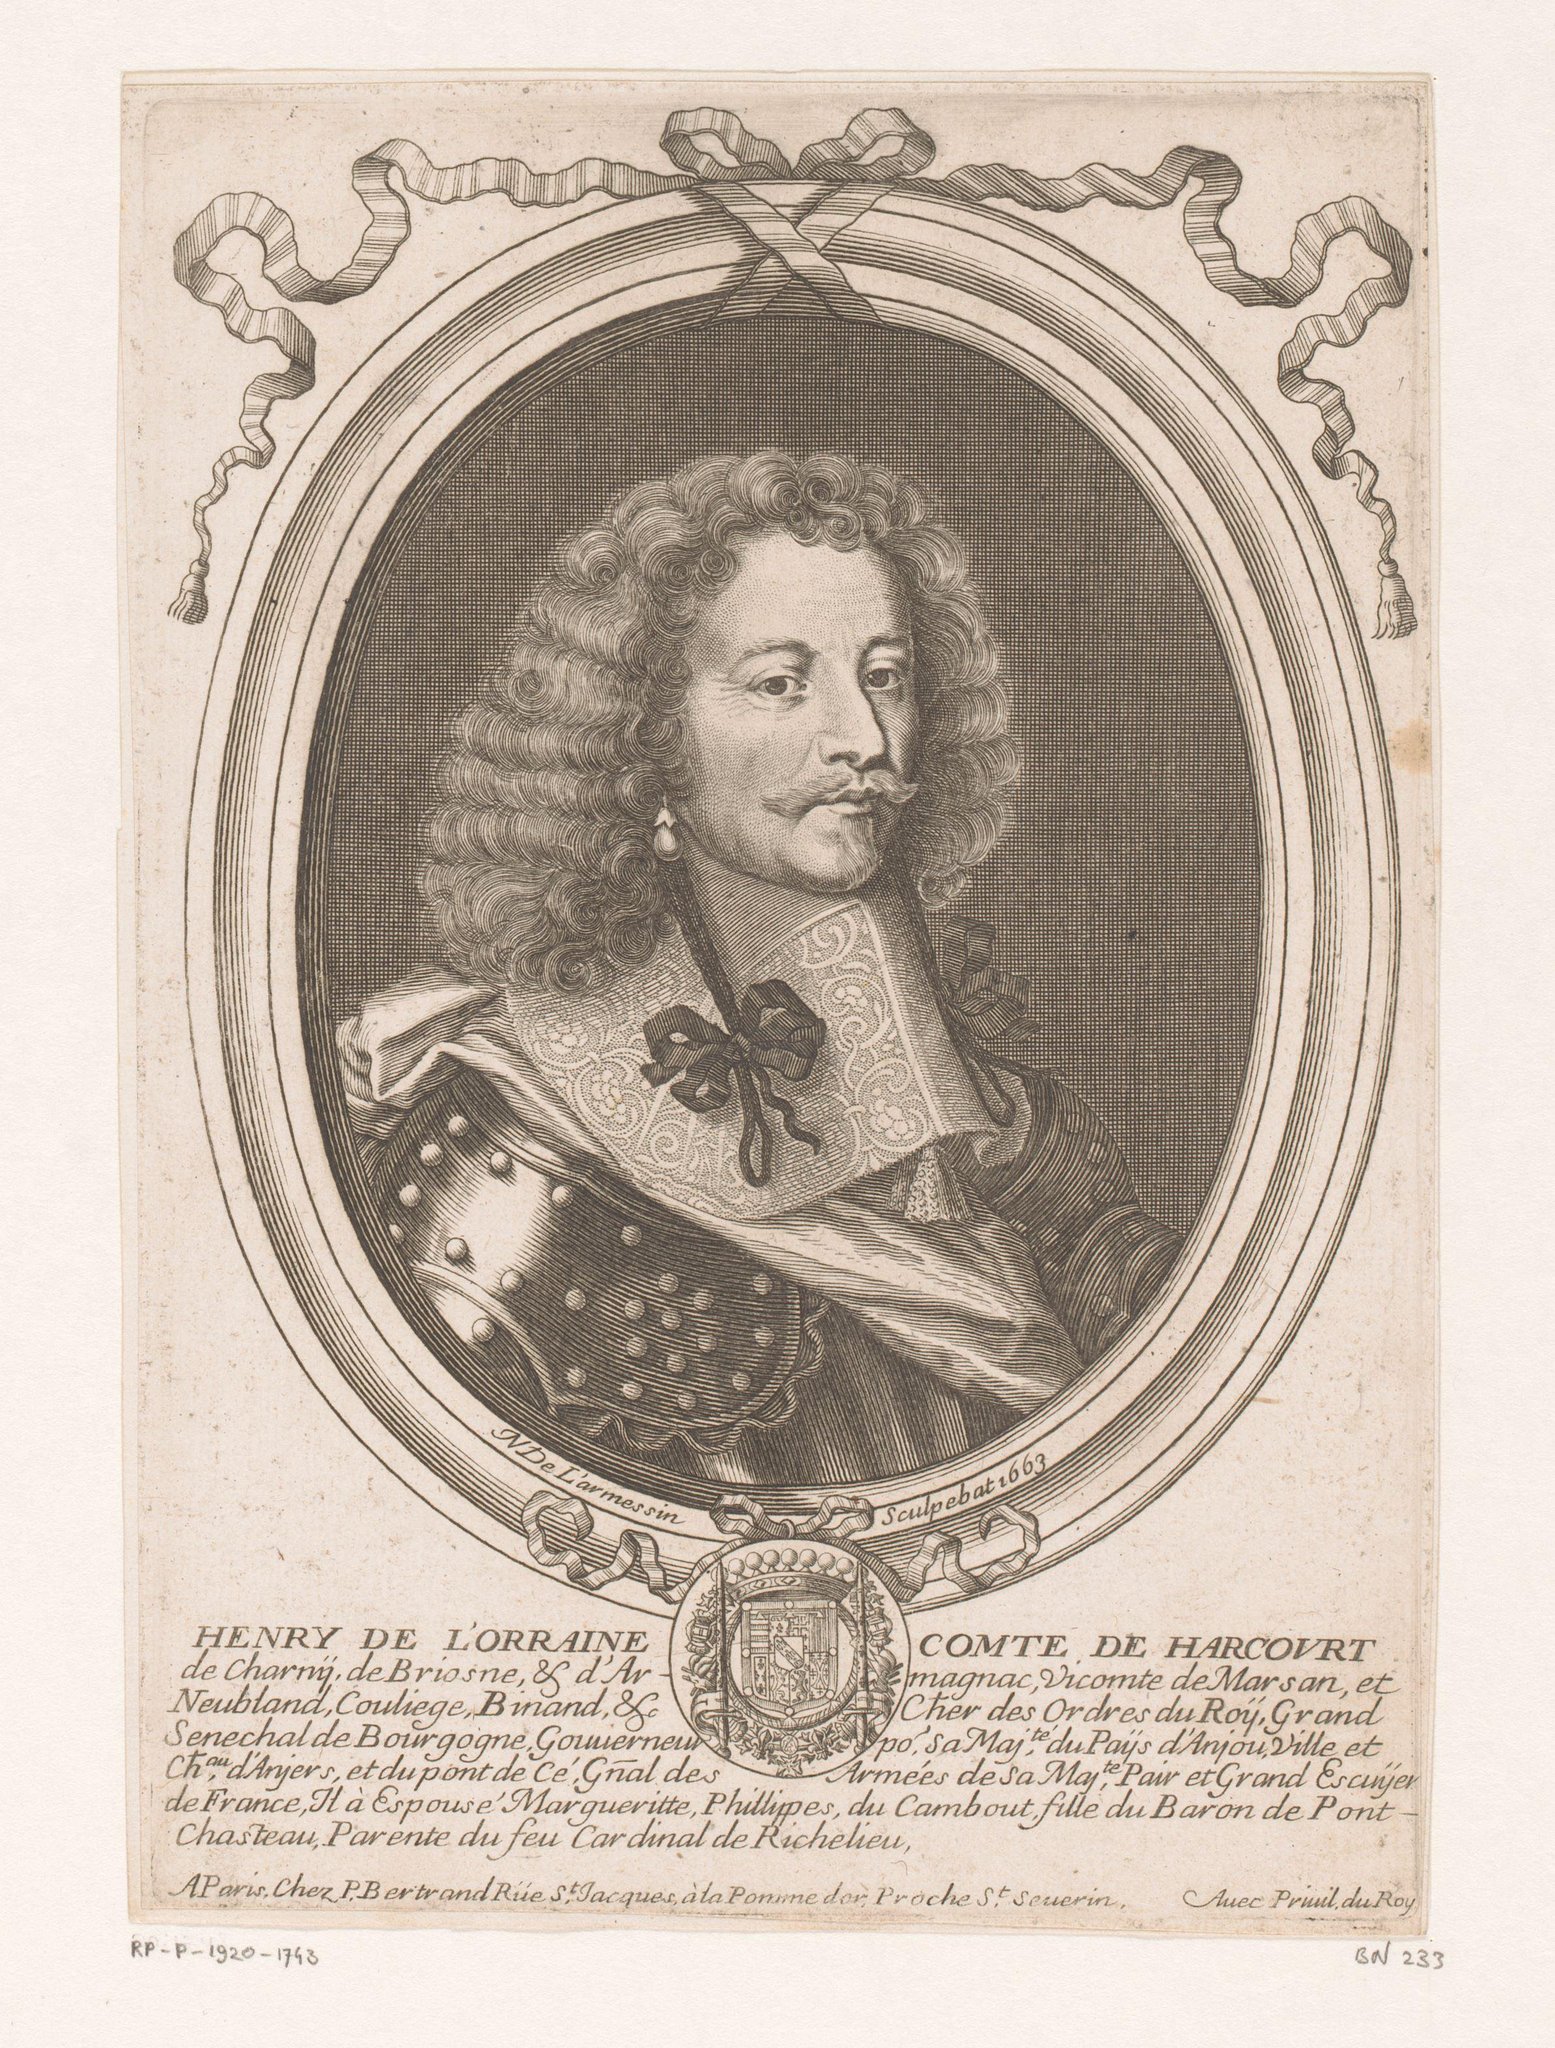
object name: print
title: Portret van Henri de Lorraine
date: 1663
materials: paper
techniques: engraving, etching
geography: france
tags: historical persons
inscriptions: collector's mark: Lugt 2228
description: Maakt deel uit van een grootschalige serie met portretten van prominente figuren. Binnen de serie bevindt zich een sectie getiteld 'Les Augustes Représentations De tous les Roys De France depuis Pharamond Iusqu'à Louys XIIII'. De serie werd respectievelijk uitgegeven door Pierre Bertrand, door zijn weduwe en door De Larmessin zelf.